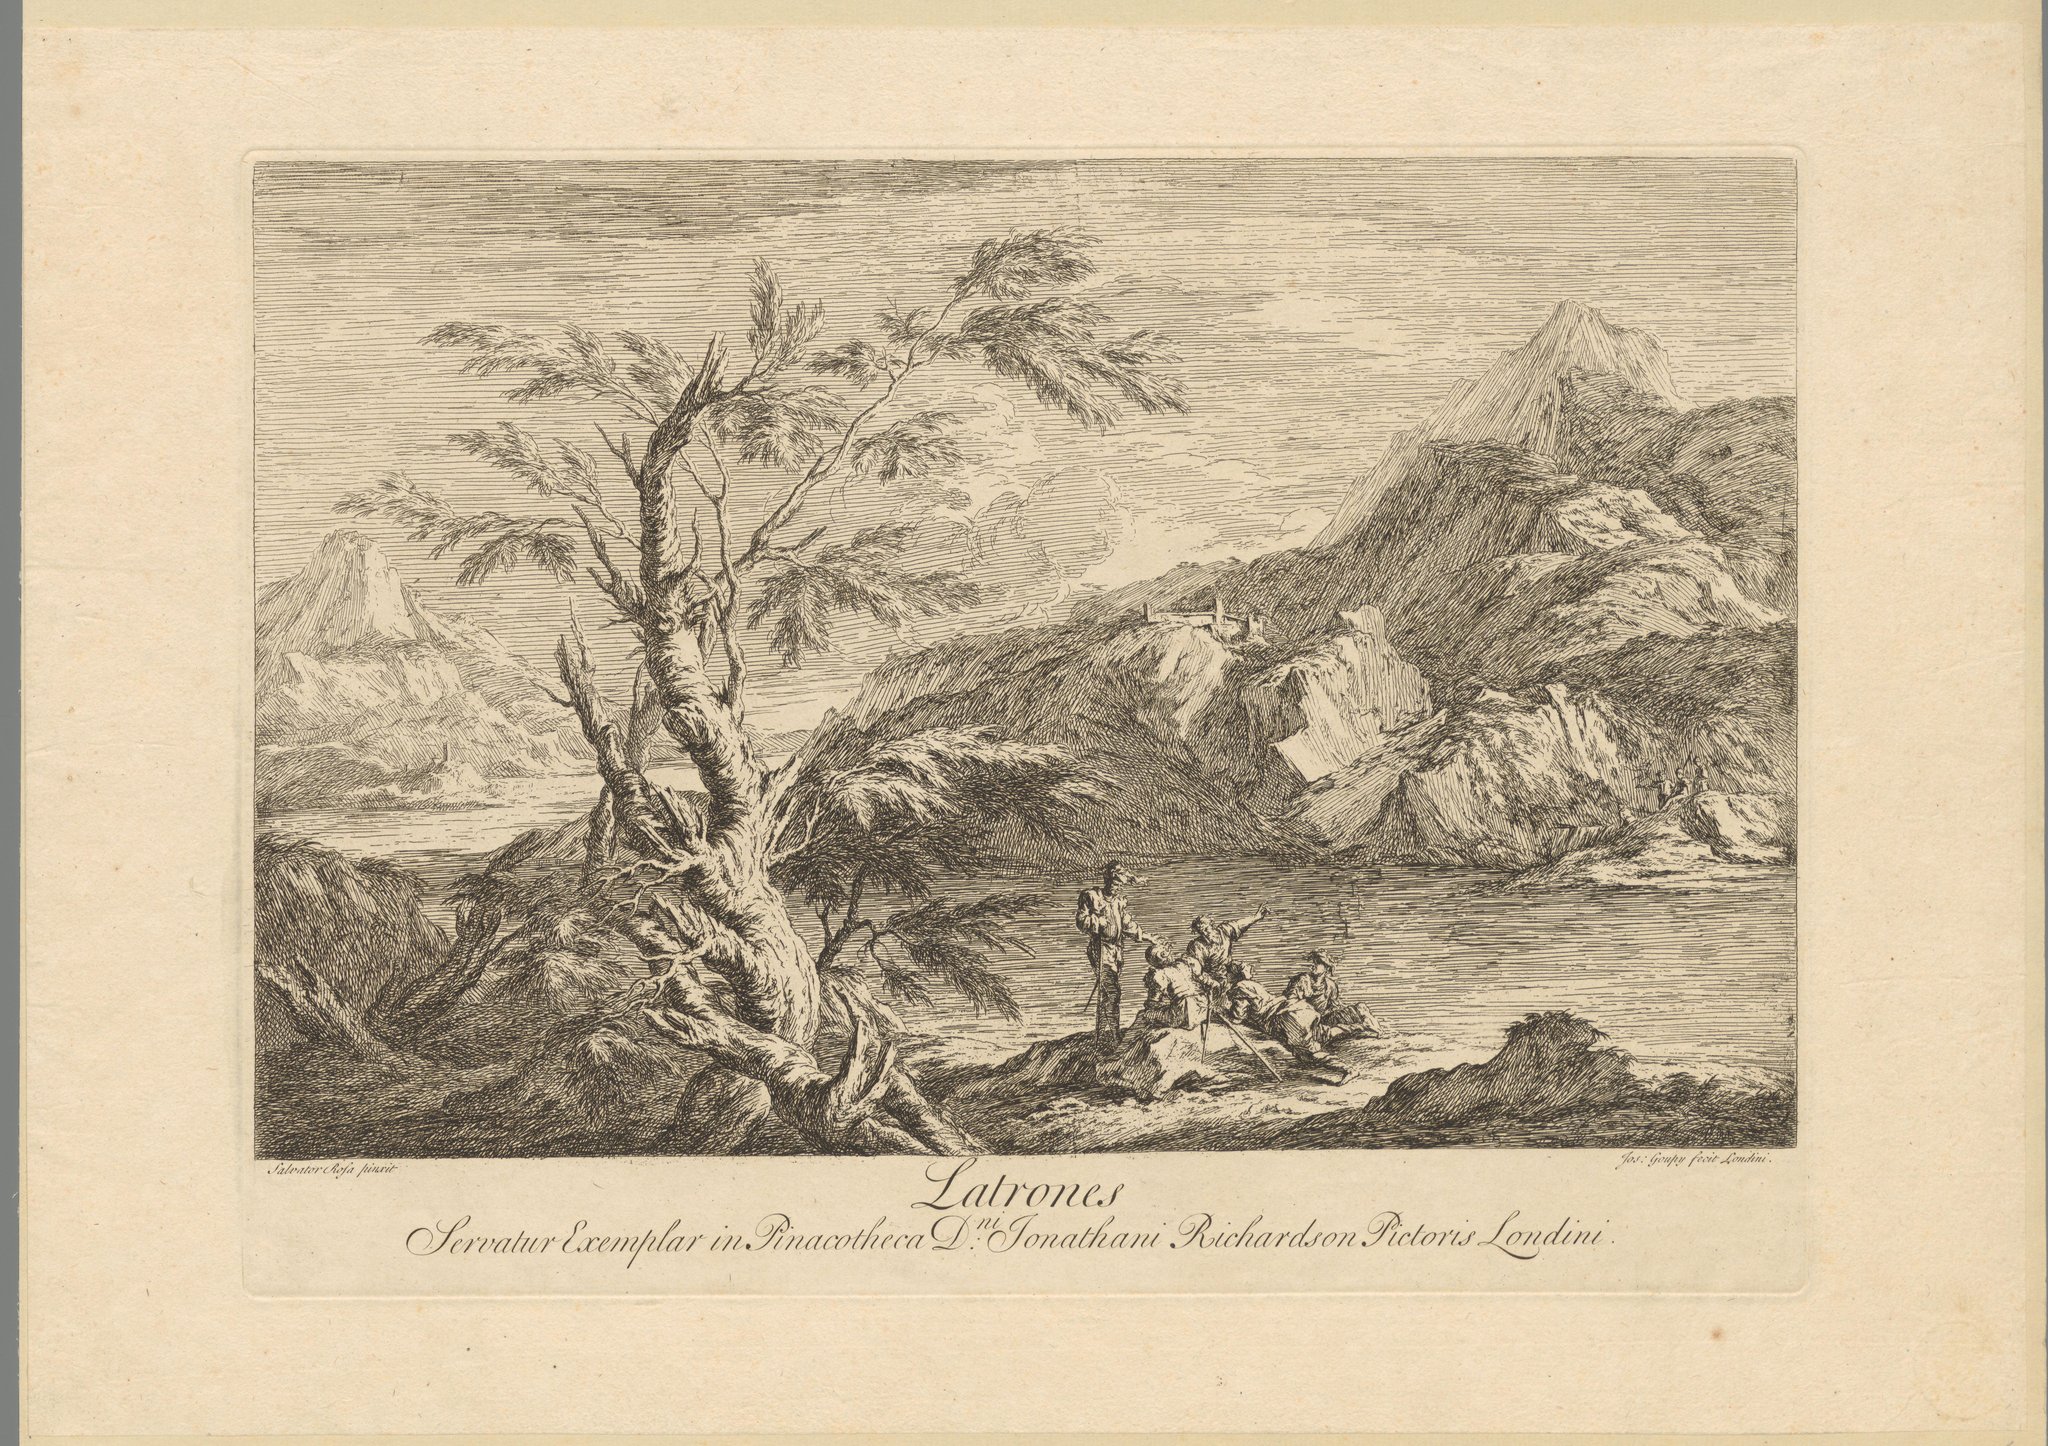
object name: print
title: Rovers aan de oever van een rivier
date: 1680-1747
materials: paper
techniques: etching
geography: london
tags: river bank, robber, (high) hill (+ landscape with figures, staffage)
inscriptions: collector's mark: Lugt 2228